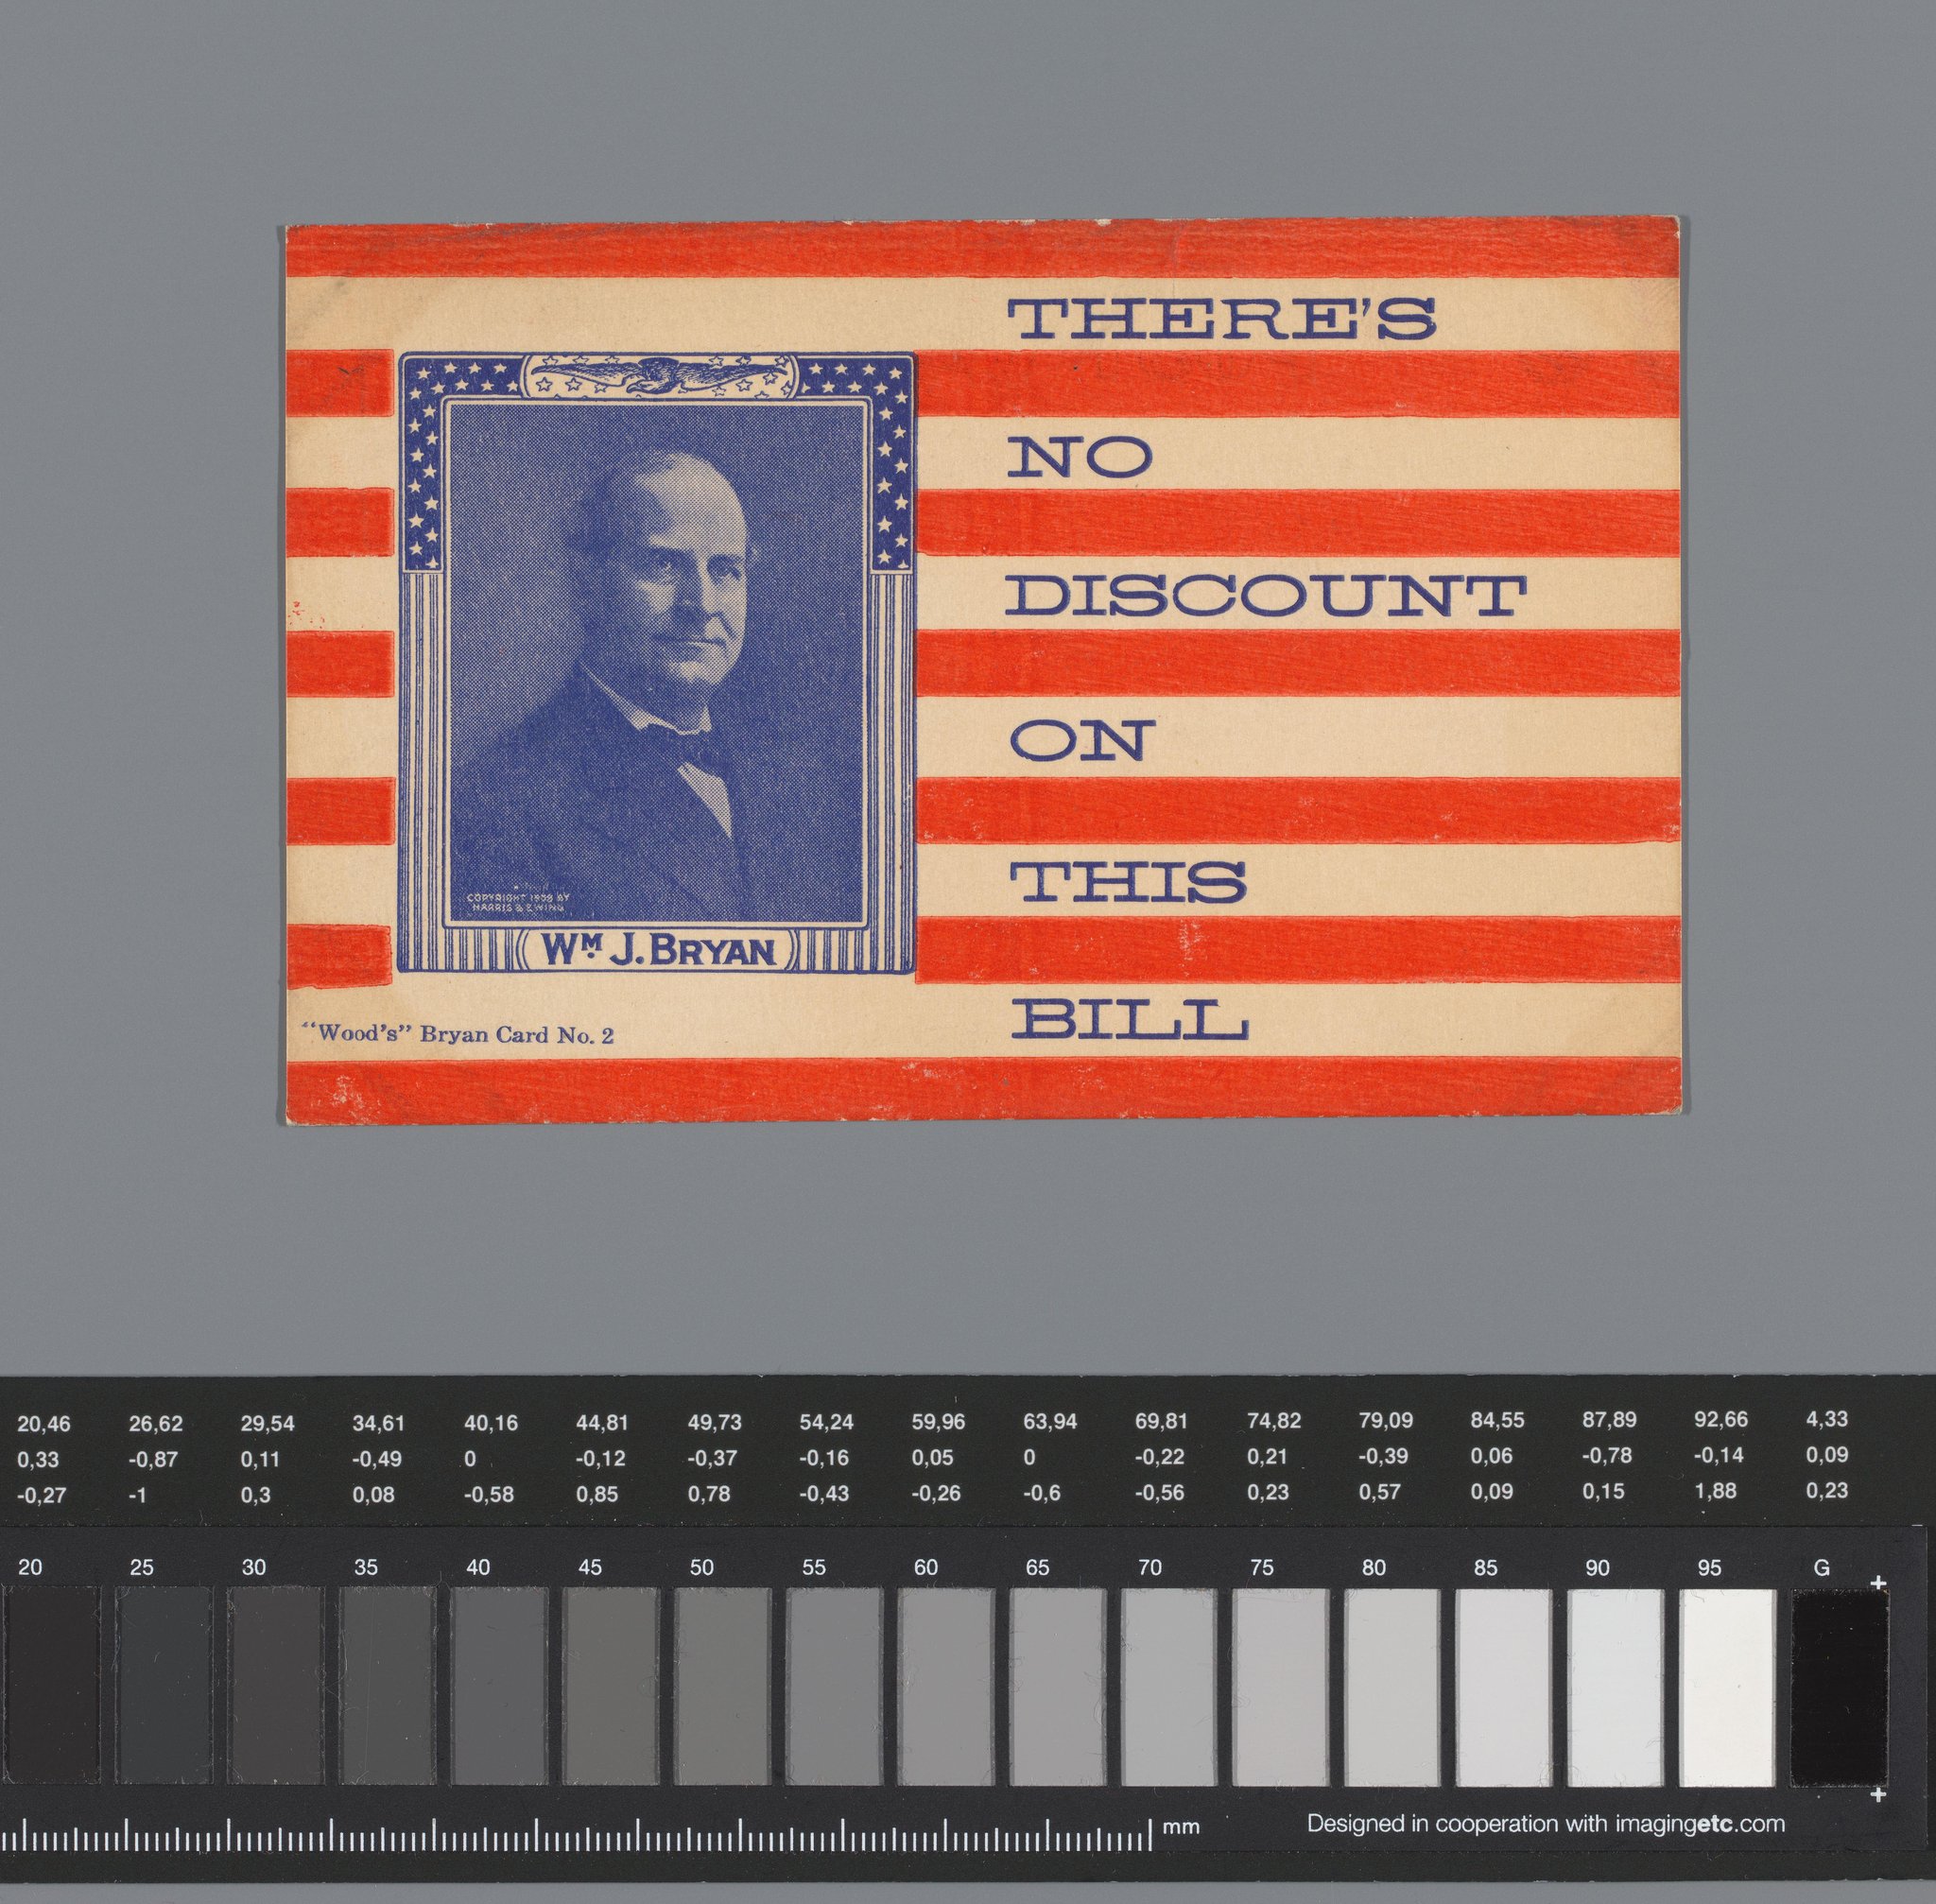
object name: ansichtkaart, prentbriefkaart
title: Prentbriefkaart gebruikt als campagnemateriaal voor de presidentskandidaat William Jennings Bryan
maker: Anonymous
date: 1908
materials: photographic support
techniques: photography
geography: washington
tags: politician, united states of america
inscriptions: inscription: ‘THERE’S / NO / DISCOUNT / ON / THIS / BILL / Wm J.Bryan / “Wood’s” Bryan Card No. 2’